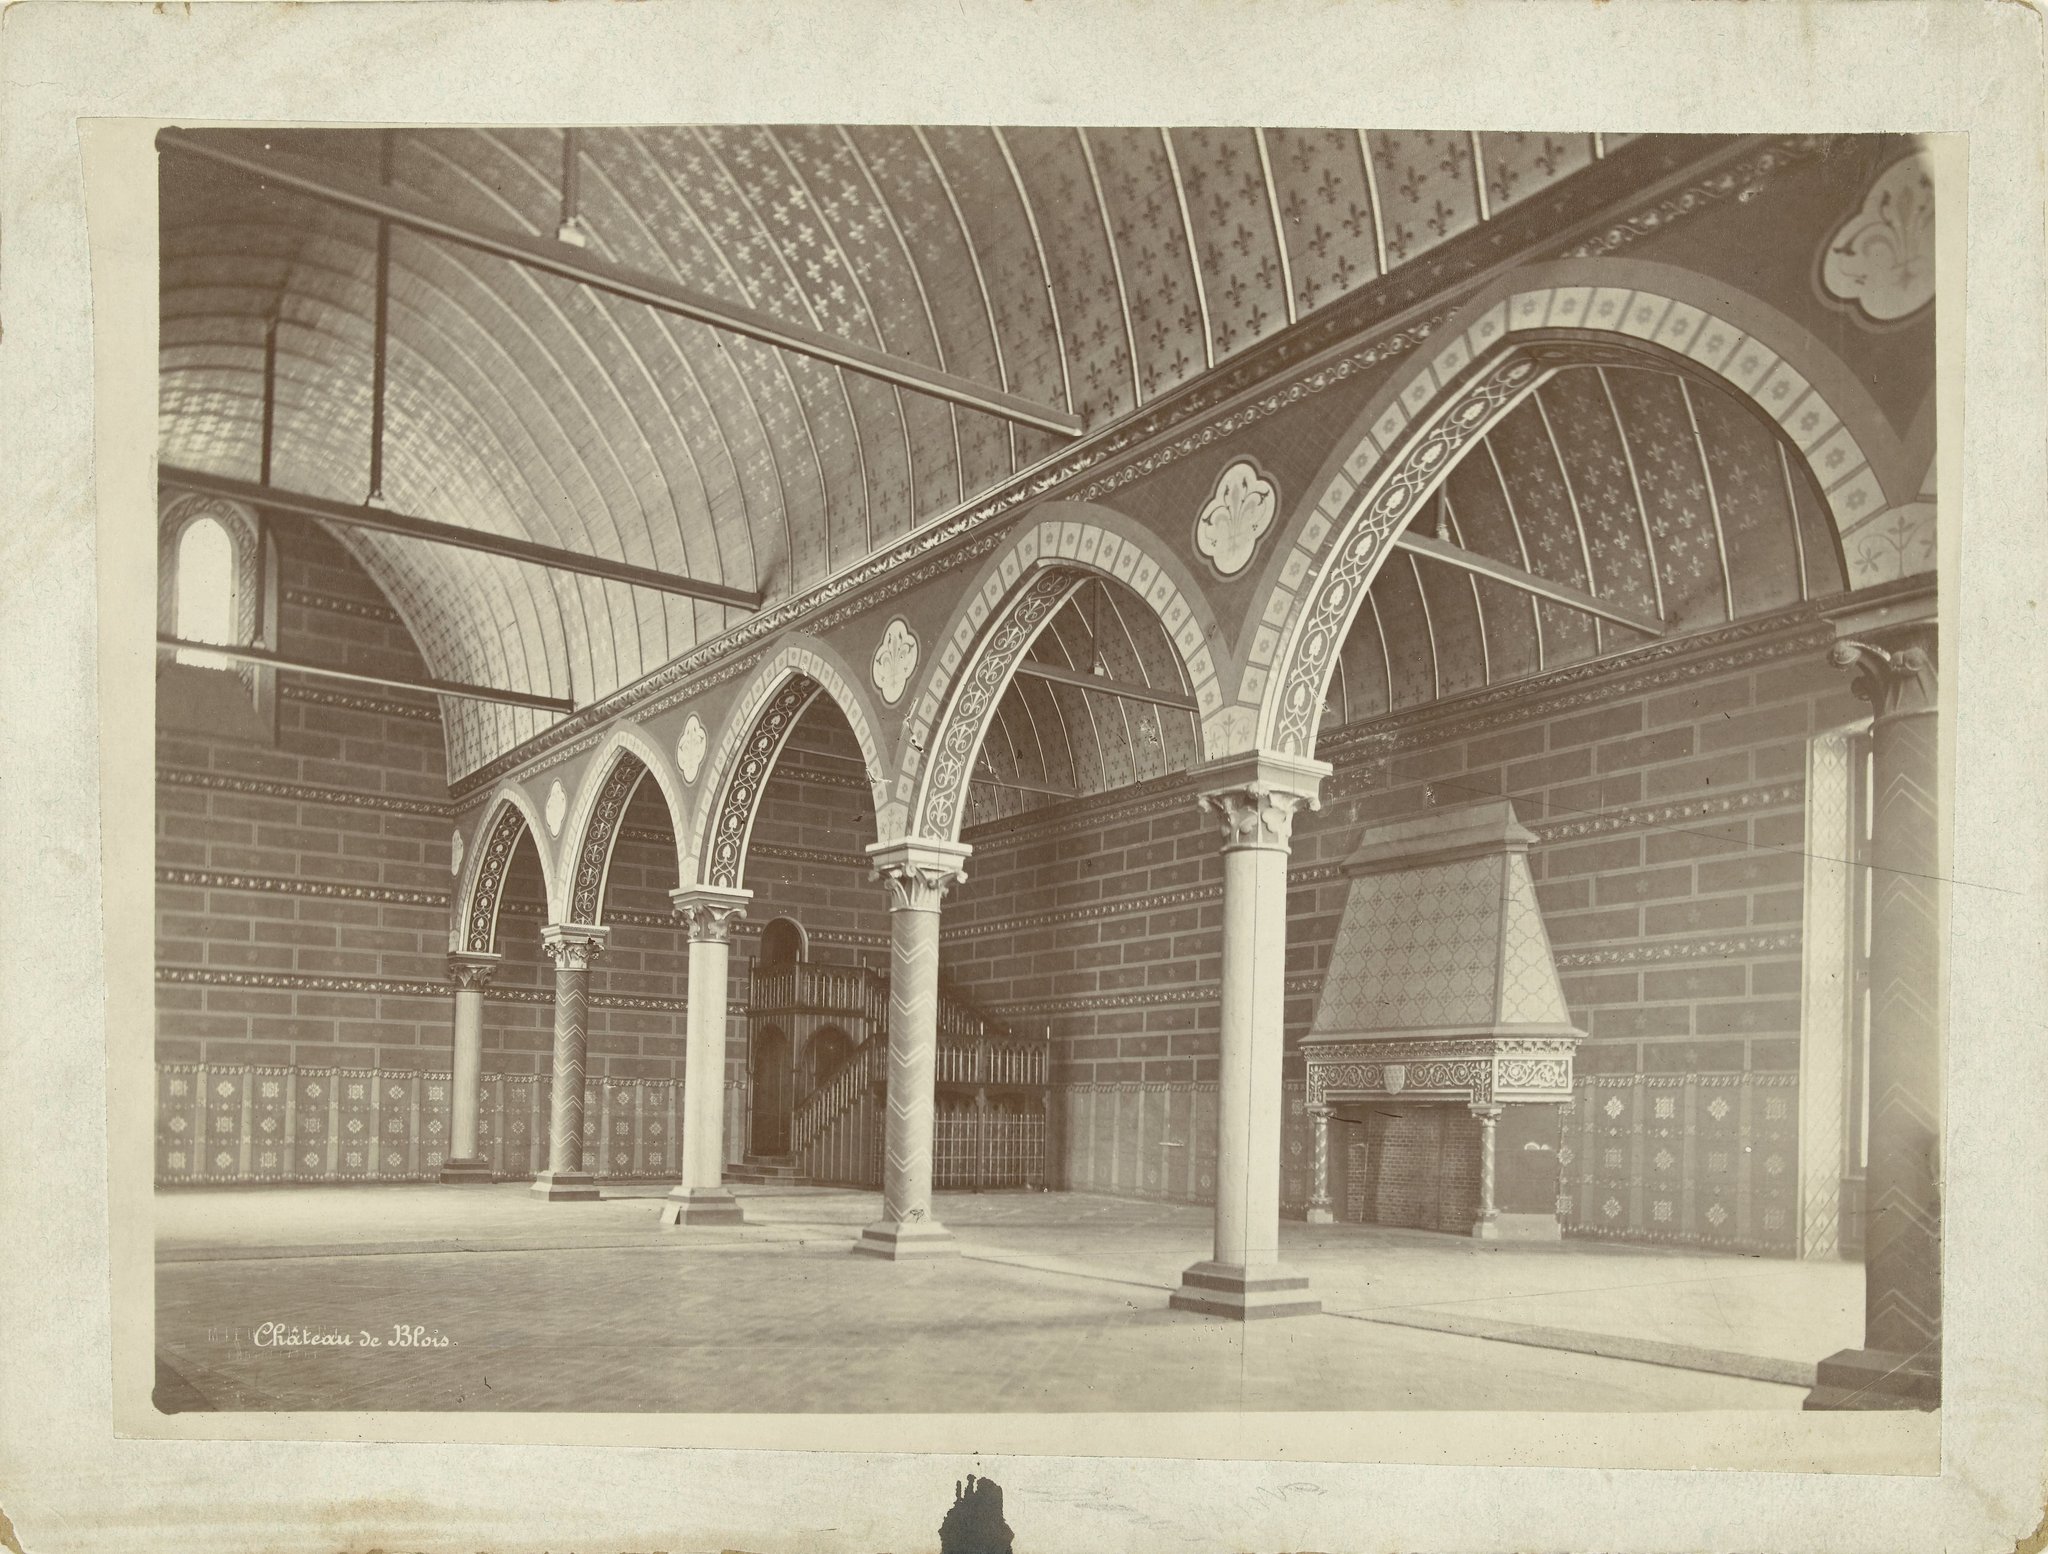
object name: photograph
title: Zaal der Staten Generaal in het kasteel van Blois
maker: séraphin-médéric mieusement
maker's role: fotograaf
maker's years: 1840-1905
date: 1870-1890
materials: cardboard, paper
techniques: albumen print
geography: blois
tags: castle - aa - civic architecture: inside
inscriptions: inscription: ‘Château de Blois’, check stamp: ‘Mieusement/ Photographe’, number: ‘N 289’, collector's mark: Lugt 3937